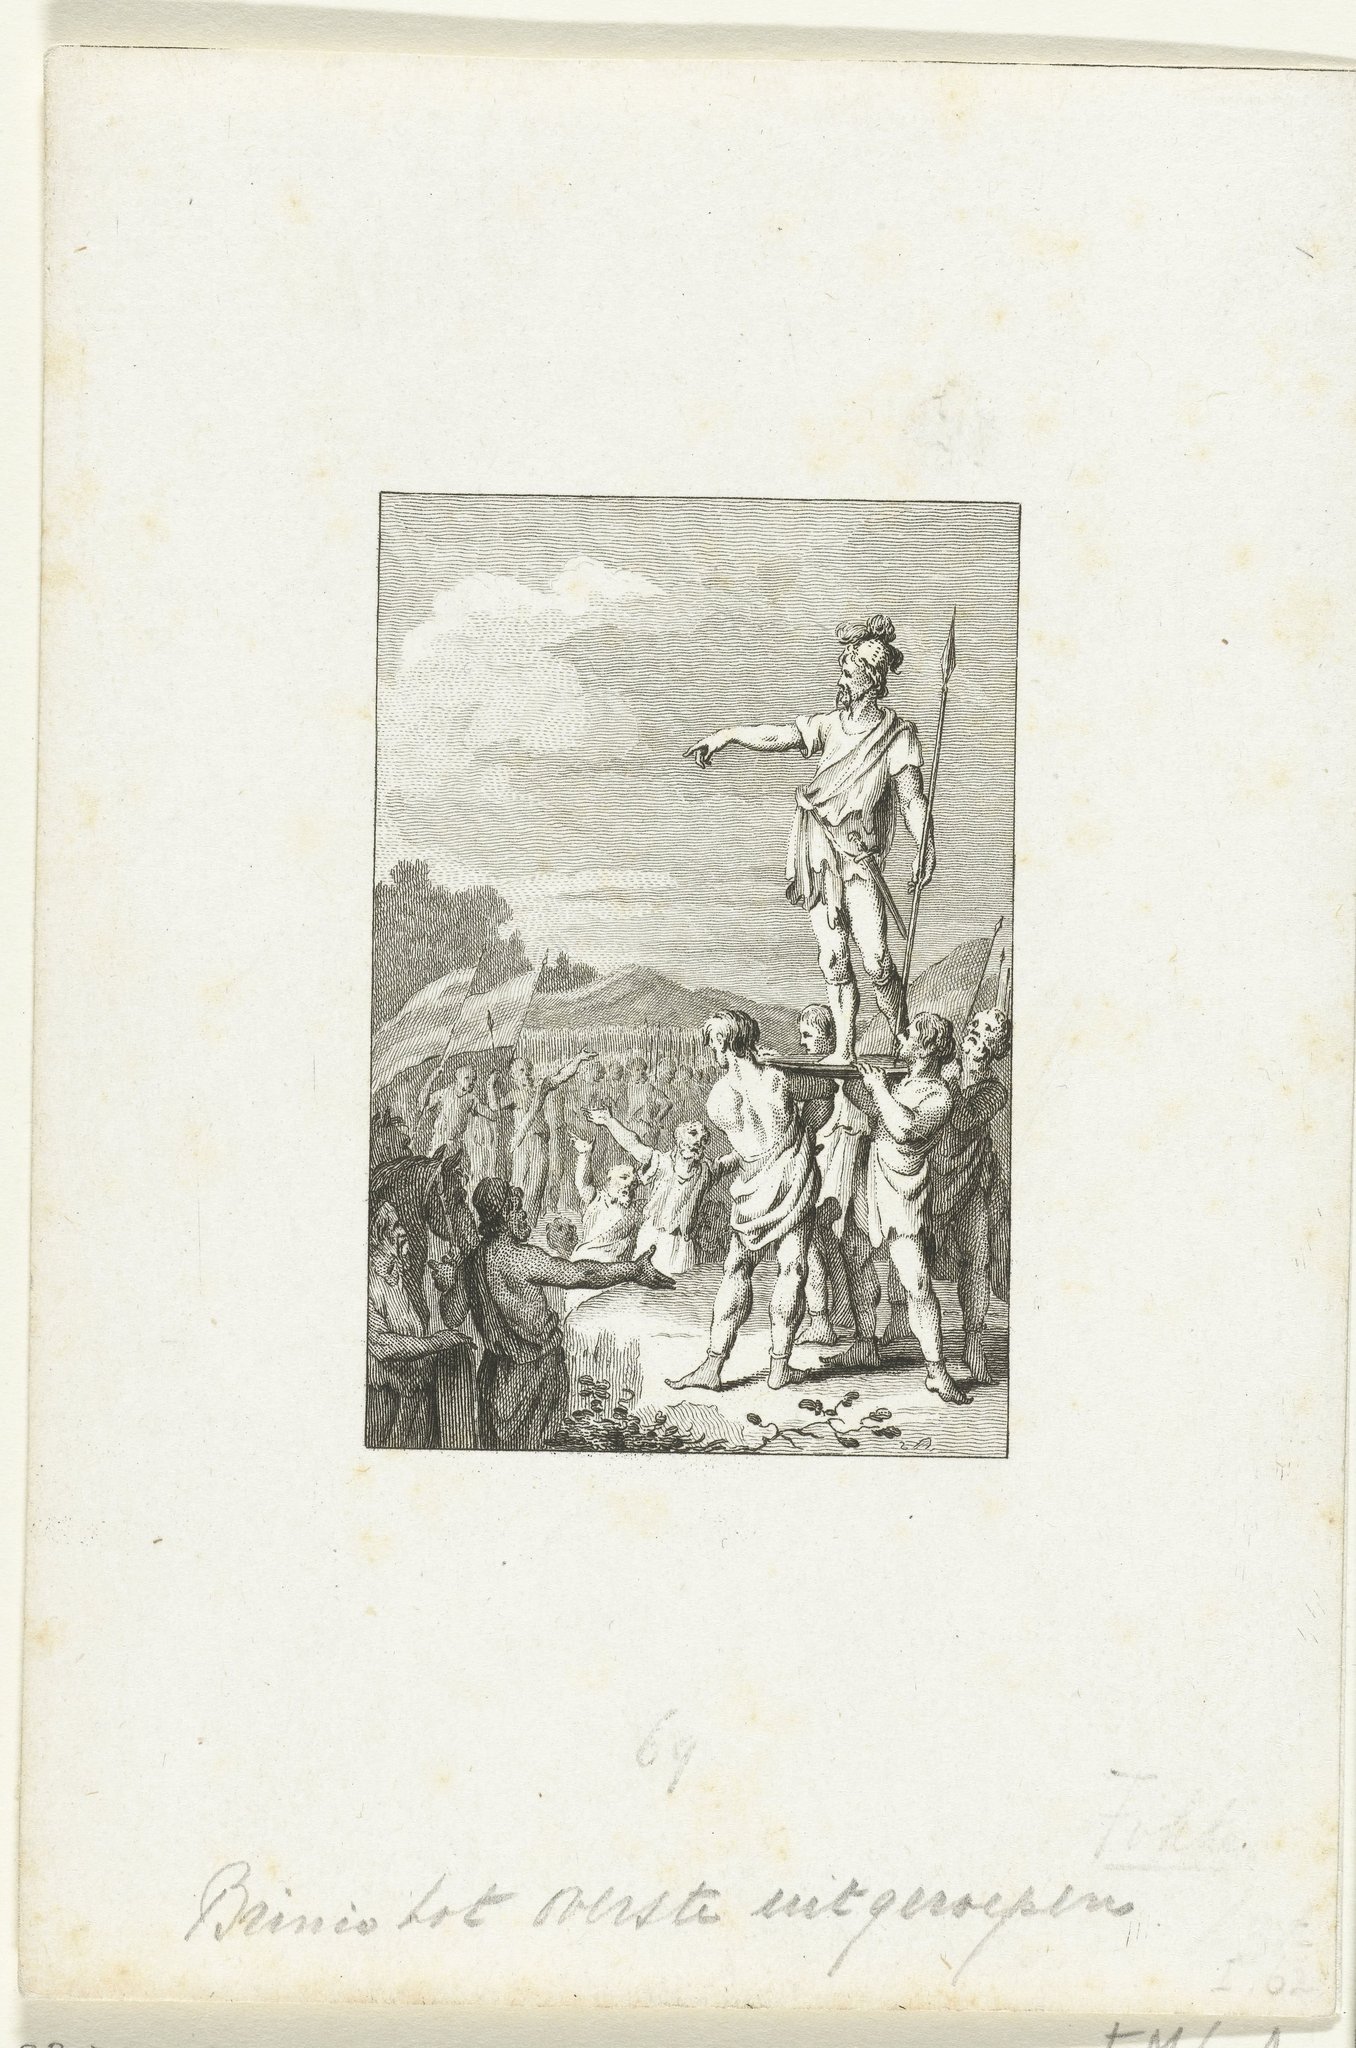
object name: history print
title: Brinno uitgeroepen tot leider van de Kanninefaten, 69-70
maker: Anonymous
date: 1800-1899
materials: paper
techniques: etching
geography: netherlands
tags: brinno, extinct, 'historical' peoples (with name), netherlands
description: Brinno staande op een schild wordt uitgeroepen tot leider van de Kanninefaten.